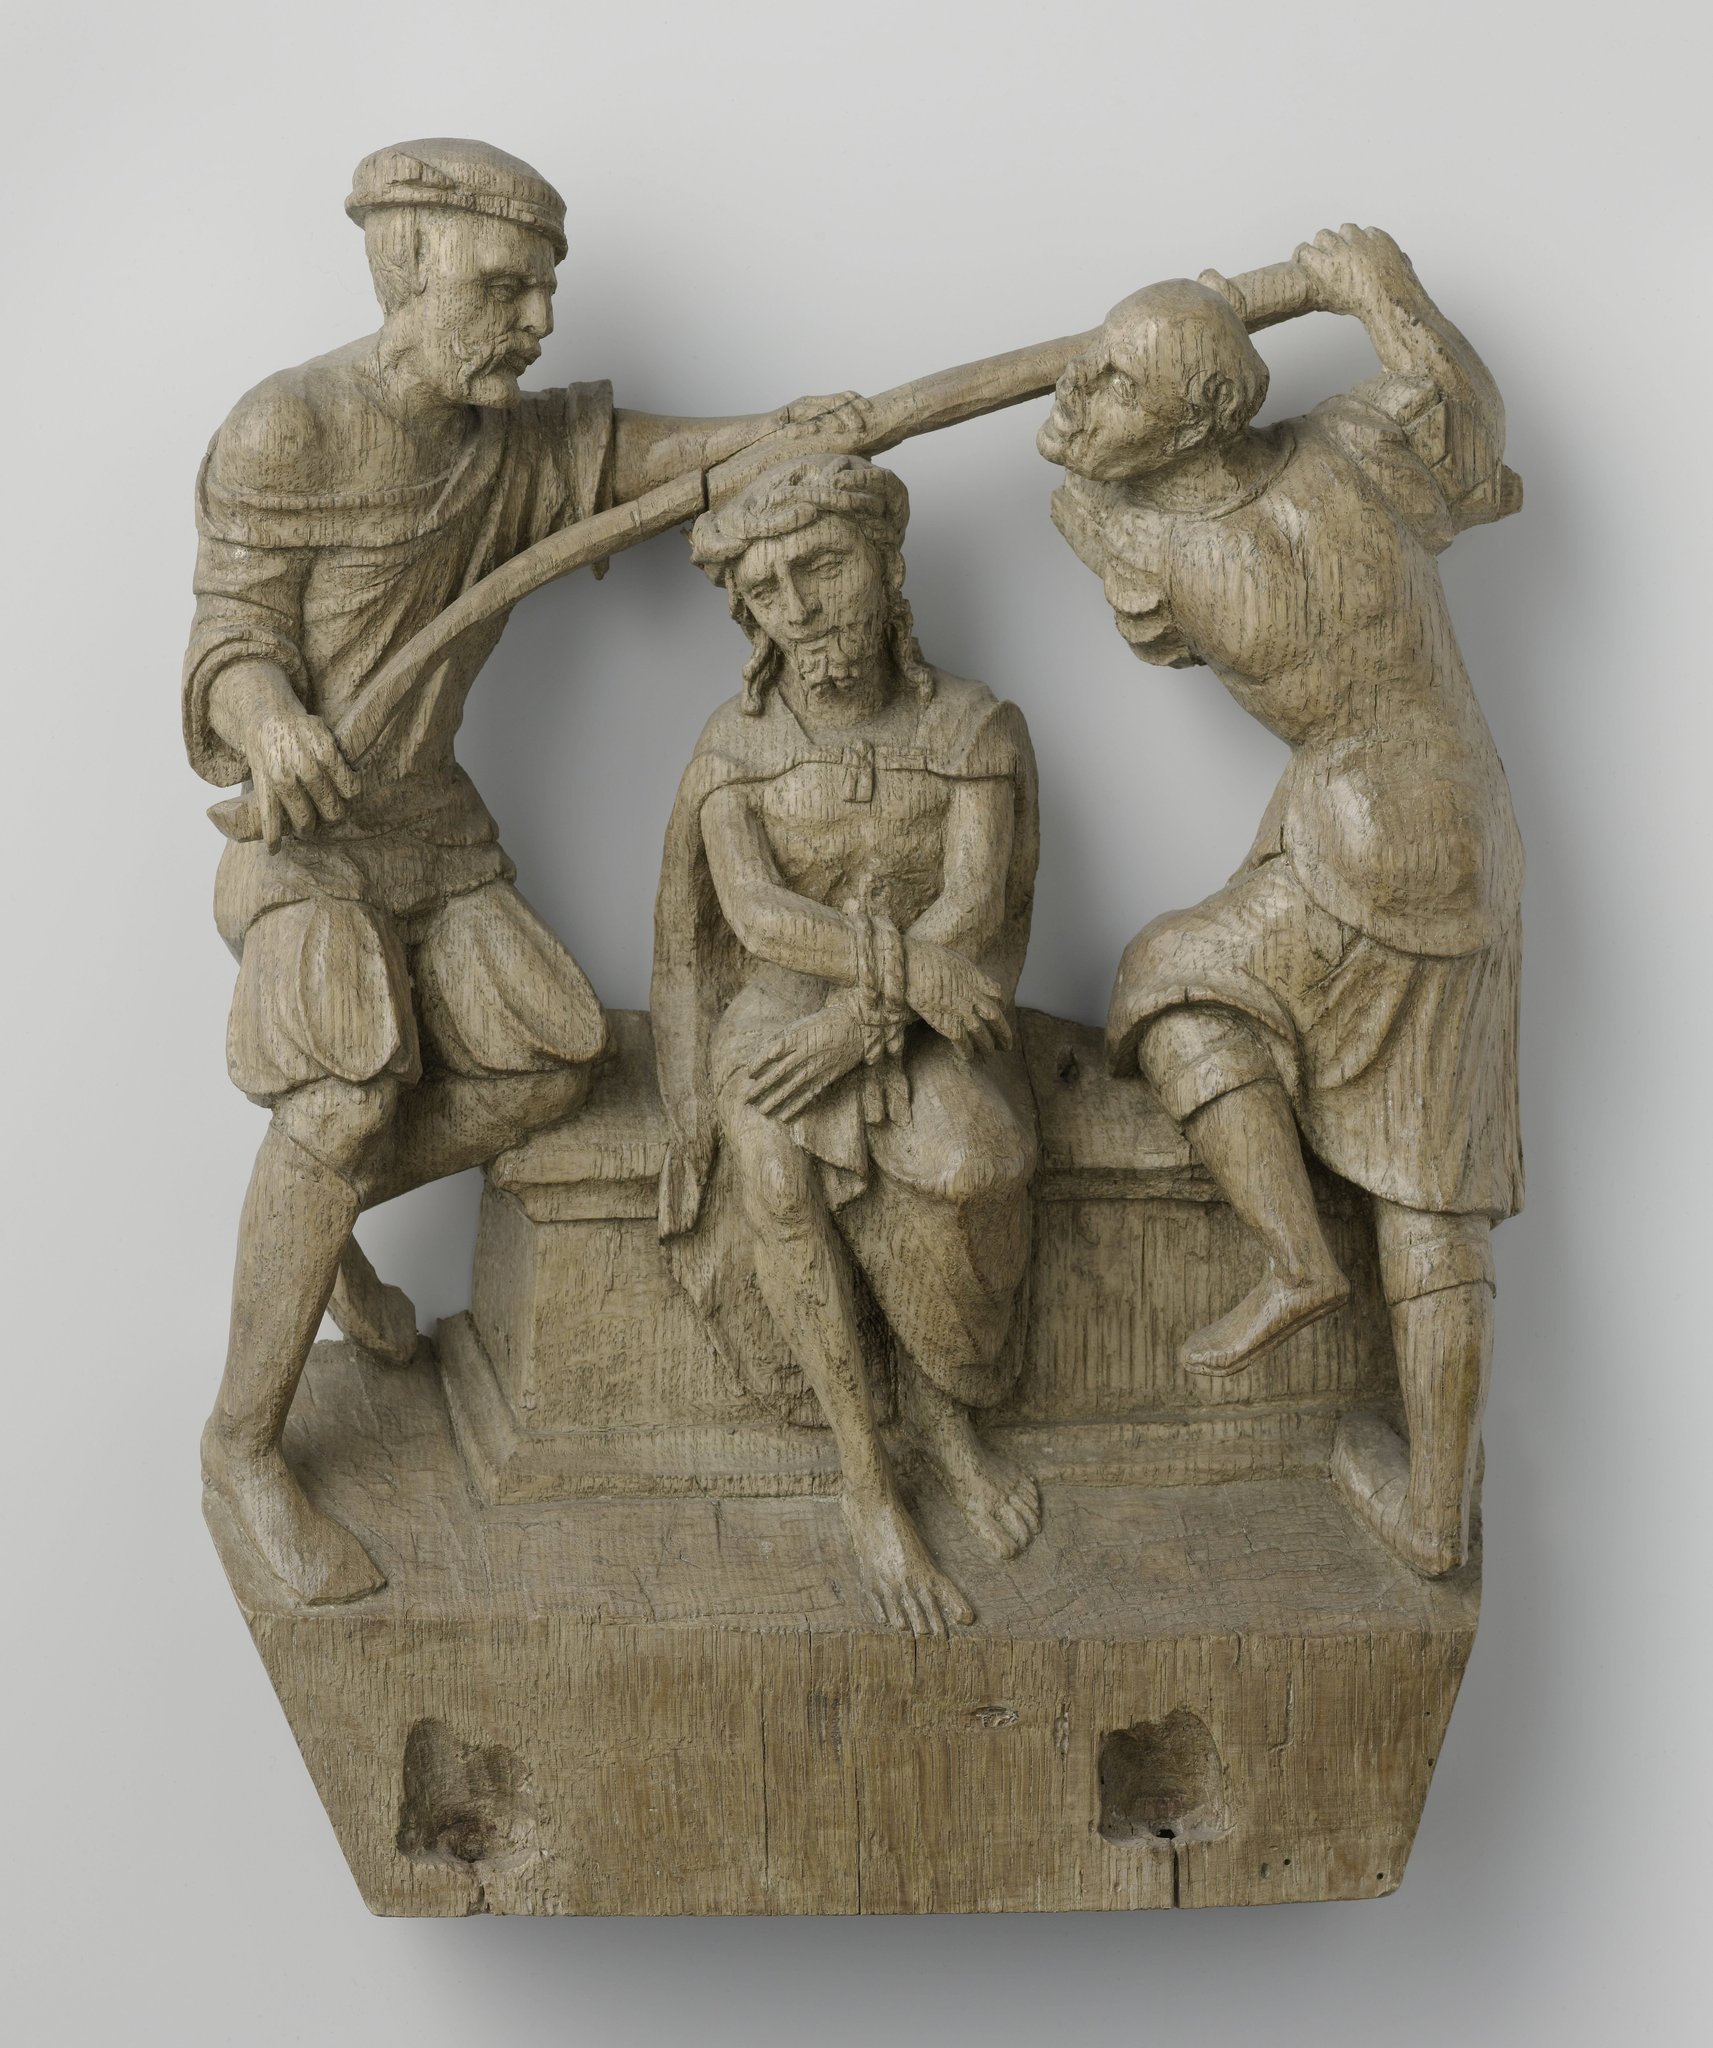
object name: sculpture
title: The Crowning with Thorns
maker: Anonymous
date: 1540-1550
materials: wood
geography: antwerp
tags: the crowning with thorns: soldiers with sticks place a thorny crown on christ's head and give him a reed (matthew 27:27-31; mark 15:16-20; john 19:2-3)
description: Op een bank zit Christus met gebonden polsen tussen twee beulsknechten, die met beide handen een lange stok op Christus' hoofd drukken, ieder daarbij met één knie steunend op de bank. Christus, in lendendoek, draagt een van de schouders afhangende mantel, die met een band voor de borst is samengestrikt en over de linkerknie is geslagen. De linker beulsknecht, met snor, draagt een baret, een pofbroek en een hemd, dat van een schouder is afgegleden; de andere, op de rug gezien, heeft de mond geopend en is gekleed in een kolder met korte siermouwen en een korte rok. Beiden dragen laarzen.